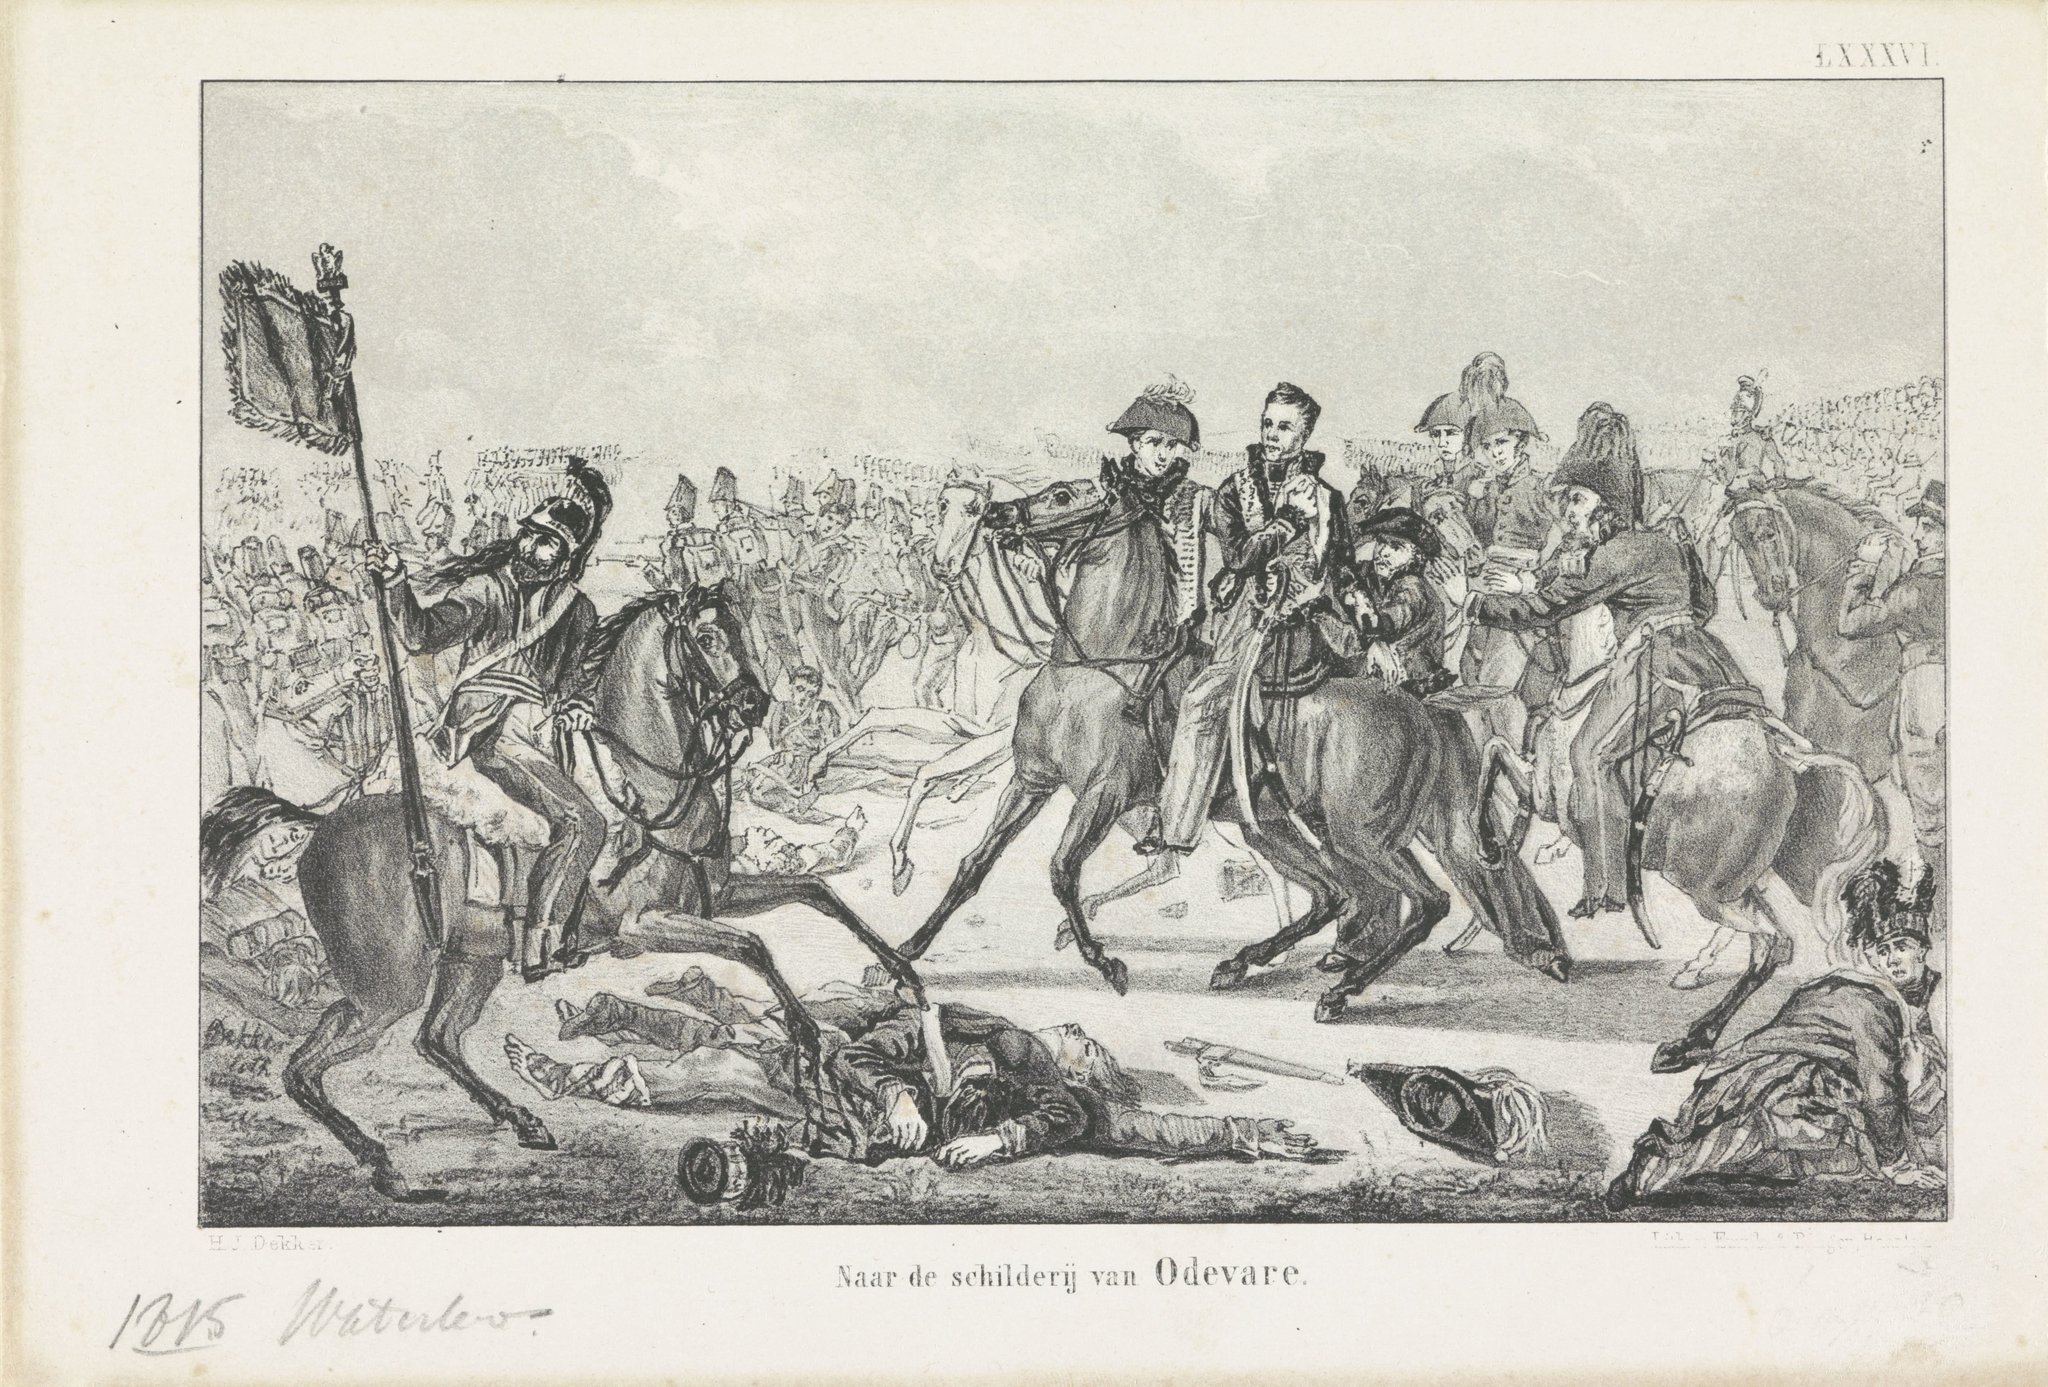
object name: history print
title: Prins van Oranje raakt gewond tijdens de slag bij Waterloo, 1815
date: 1853-1861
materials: paper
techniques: lithograph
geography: haarlem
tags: the hague, william ii of the netherlands, putting out of action by wounding, battle (+ land forces), waterloo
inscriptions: collector's mark: Lugt 2228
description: Dit nummer is een door het RPK toegevoegd nummer en staat niet in Frederik Muller, het werk waar de prent voor is gemaakt of uit afkomstig is, staat wel vermeld in Frederik Muller. Gebruikt als illustratie in: Jacob van Lennep, De geschiedenis des vaderlands in schetsen en afbeeldingen, Binger, Amsterdam 1855-1861, 8 delen, pl. LXXXVI.